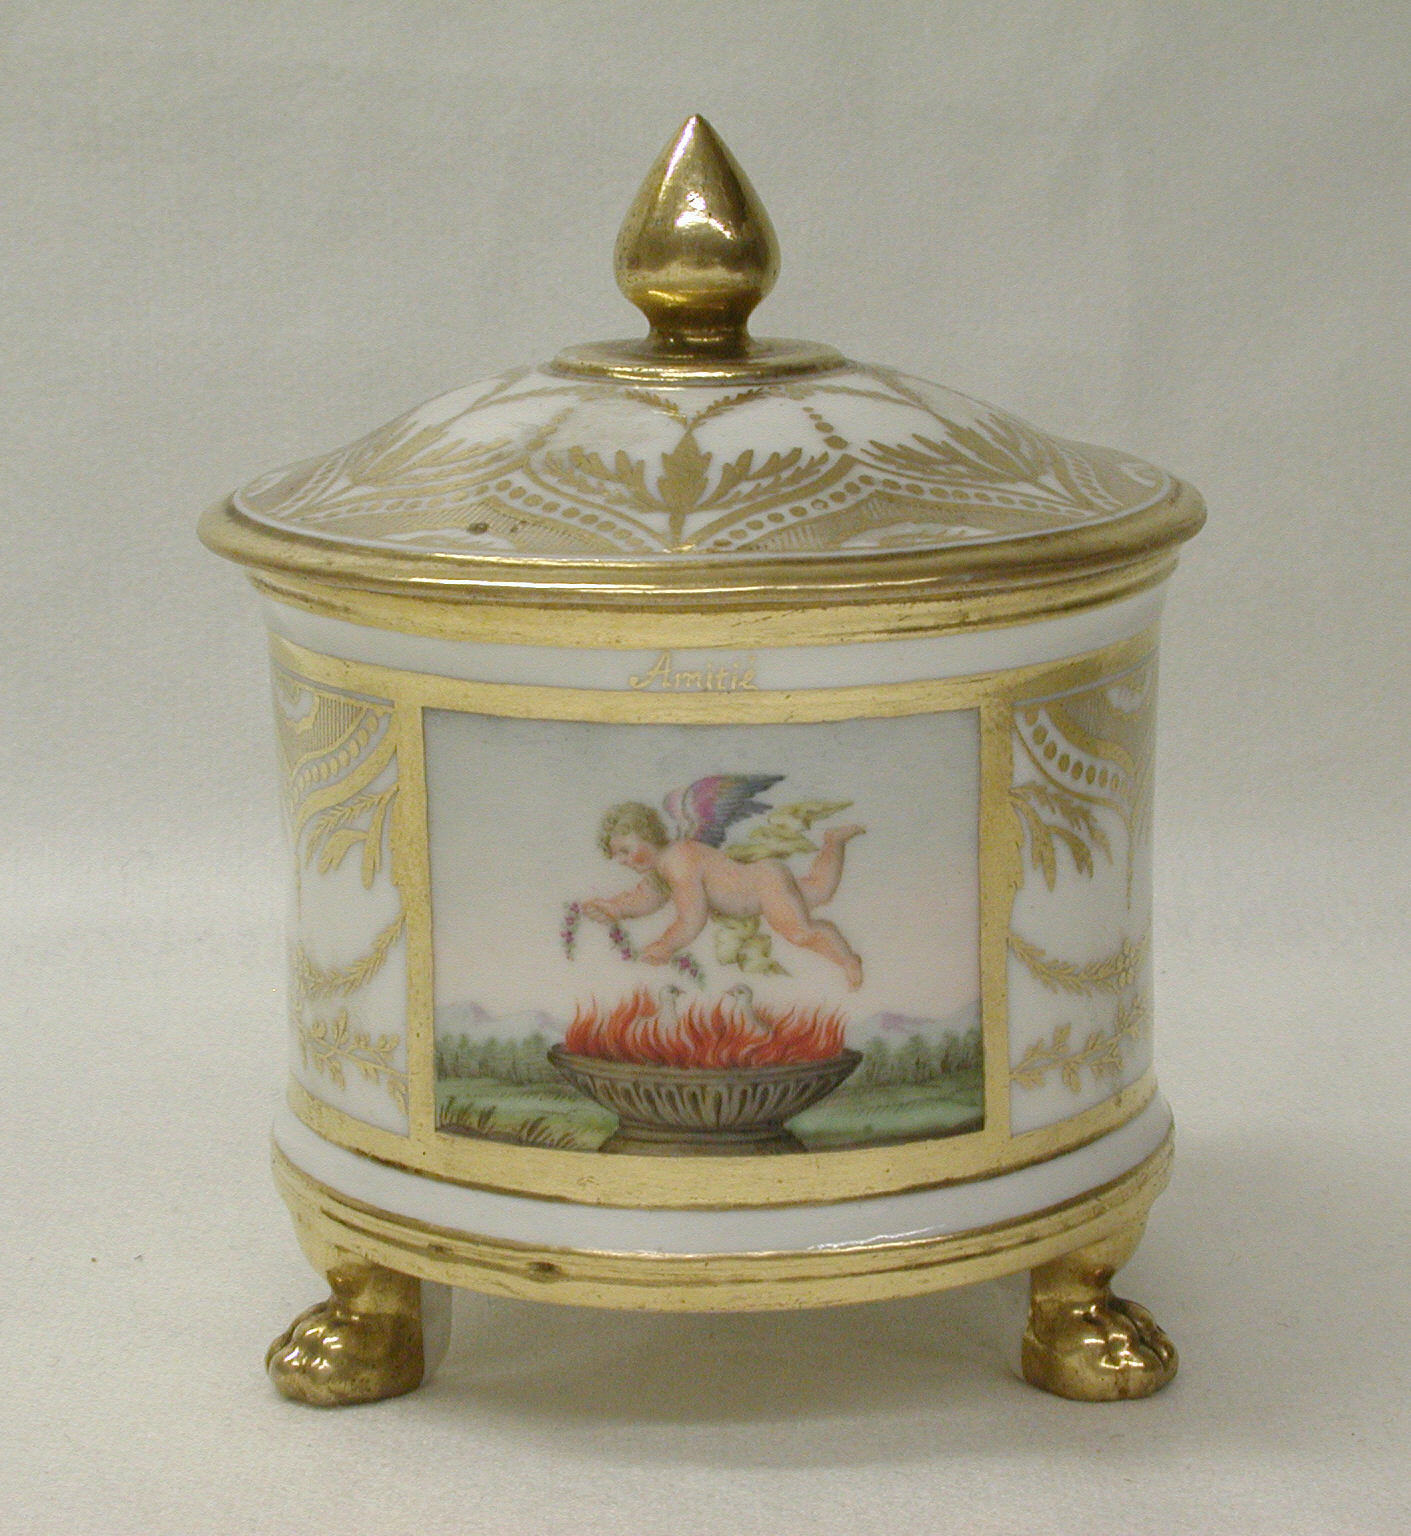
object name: sugar bowl with cover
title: Sugar bowl with cover (part of a service)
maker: royal porcelain manufactory, naples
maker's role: manufactory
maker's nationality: italian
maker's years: 1759-1819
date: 1767-1800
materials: soft paste porcelain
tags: putti,fires